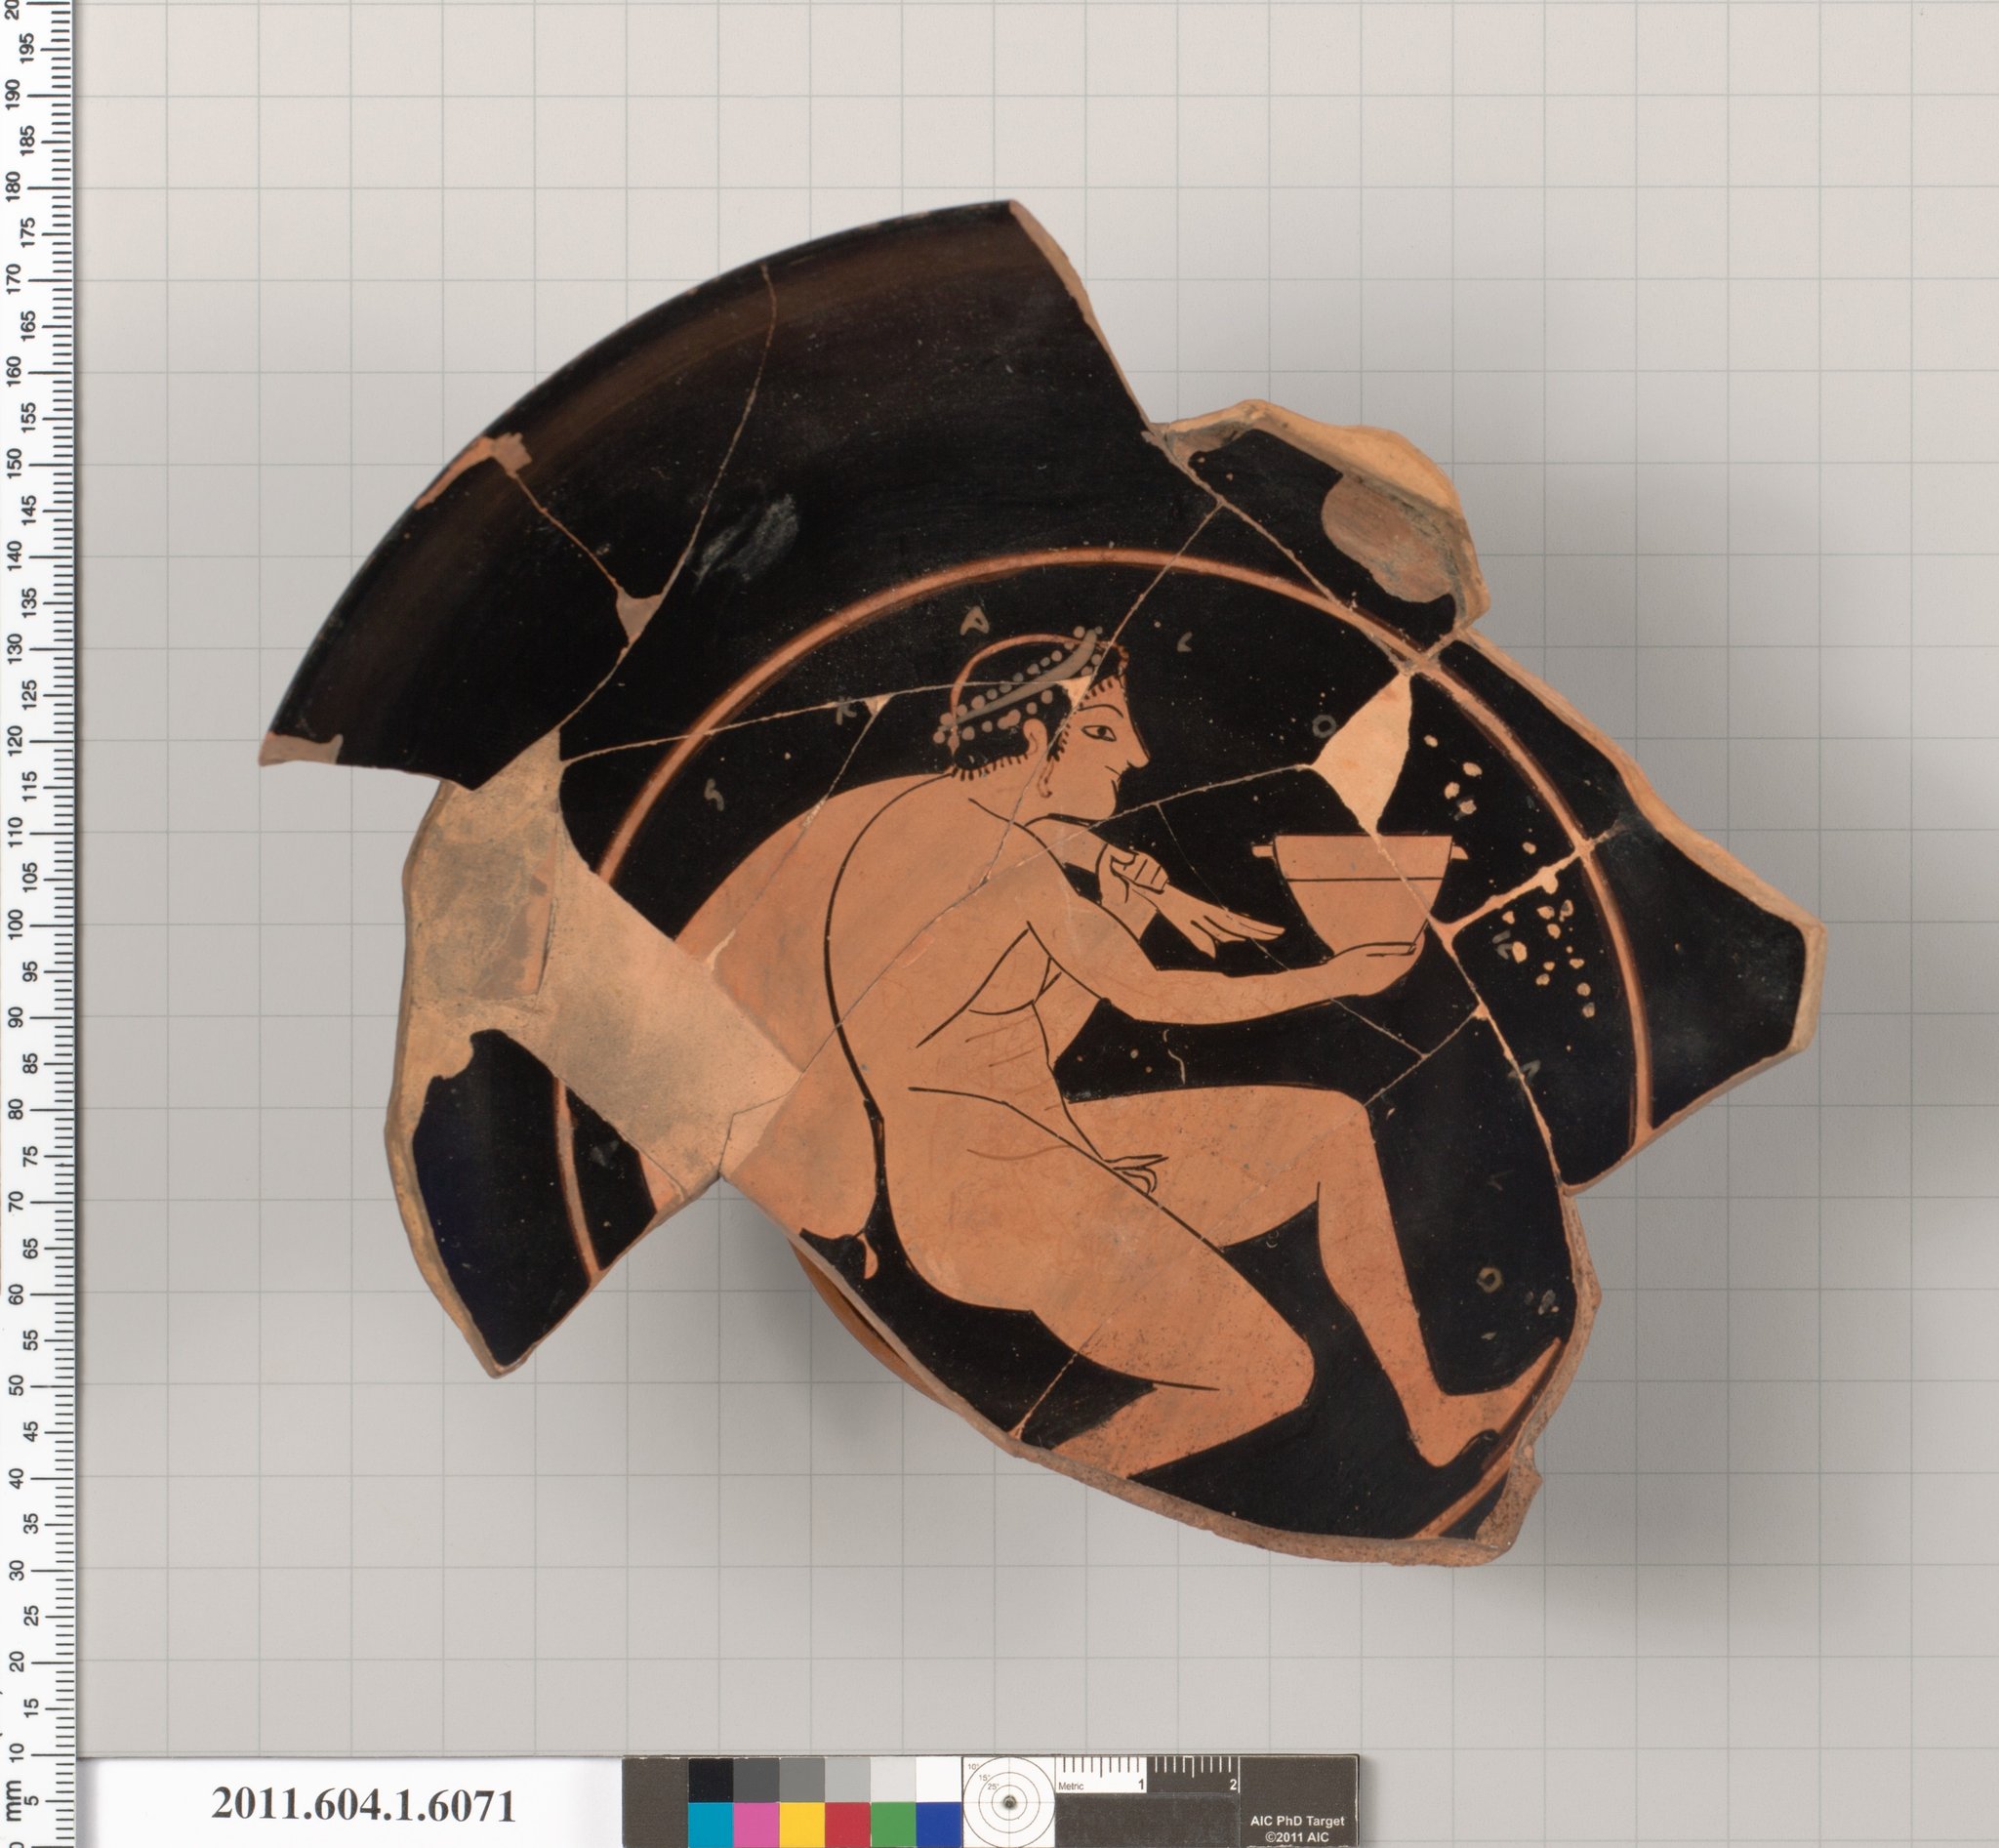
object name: kylix fragment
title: Terracotta fragment of a kylix (drinking cup)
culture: greek, attic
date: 510-500 BCE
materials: terracotta